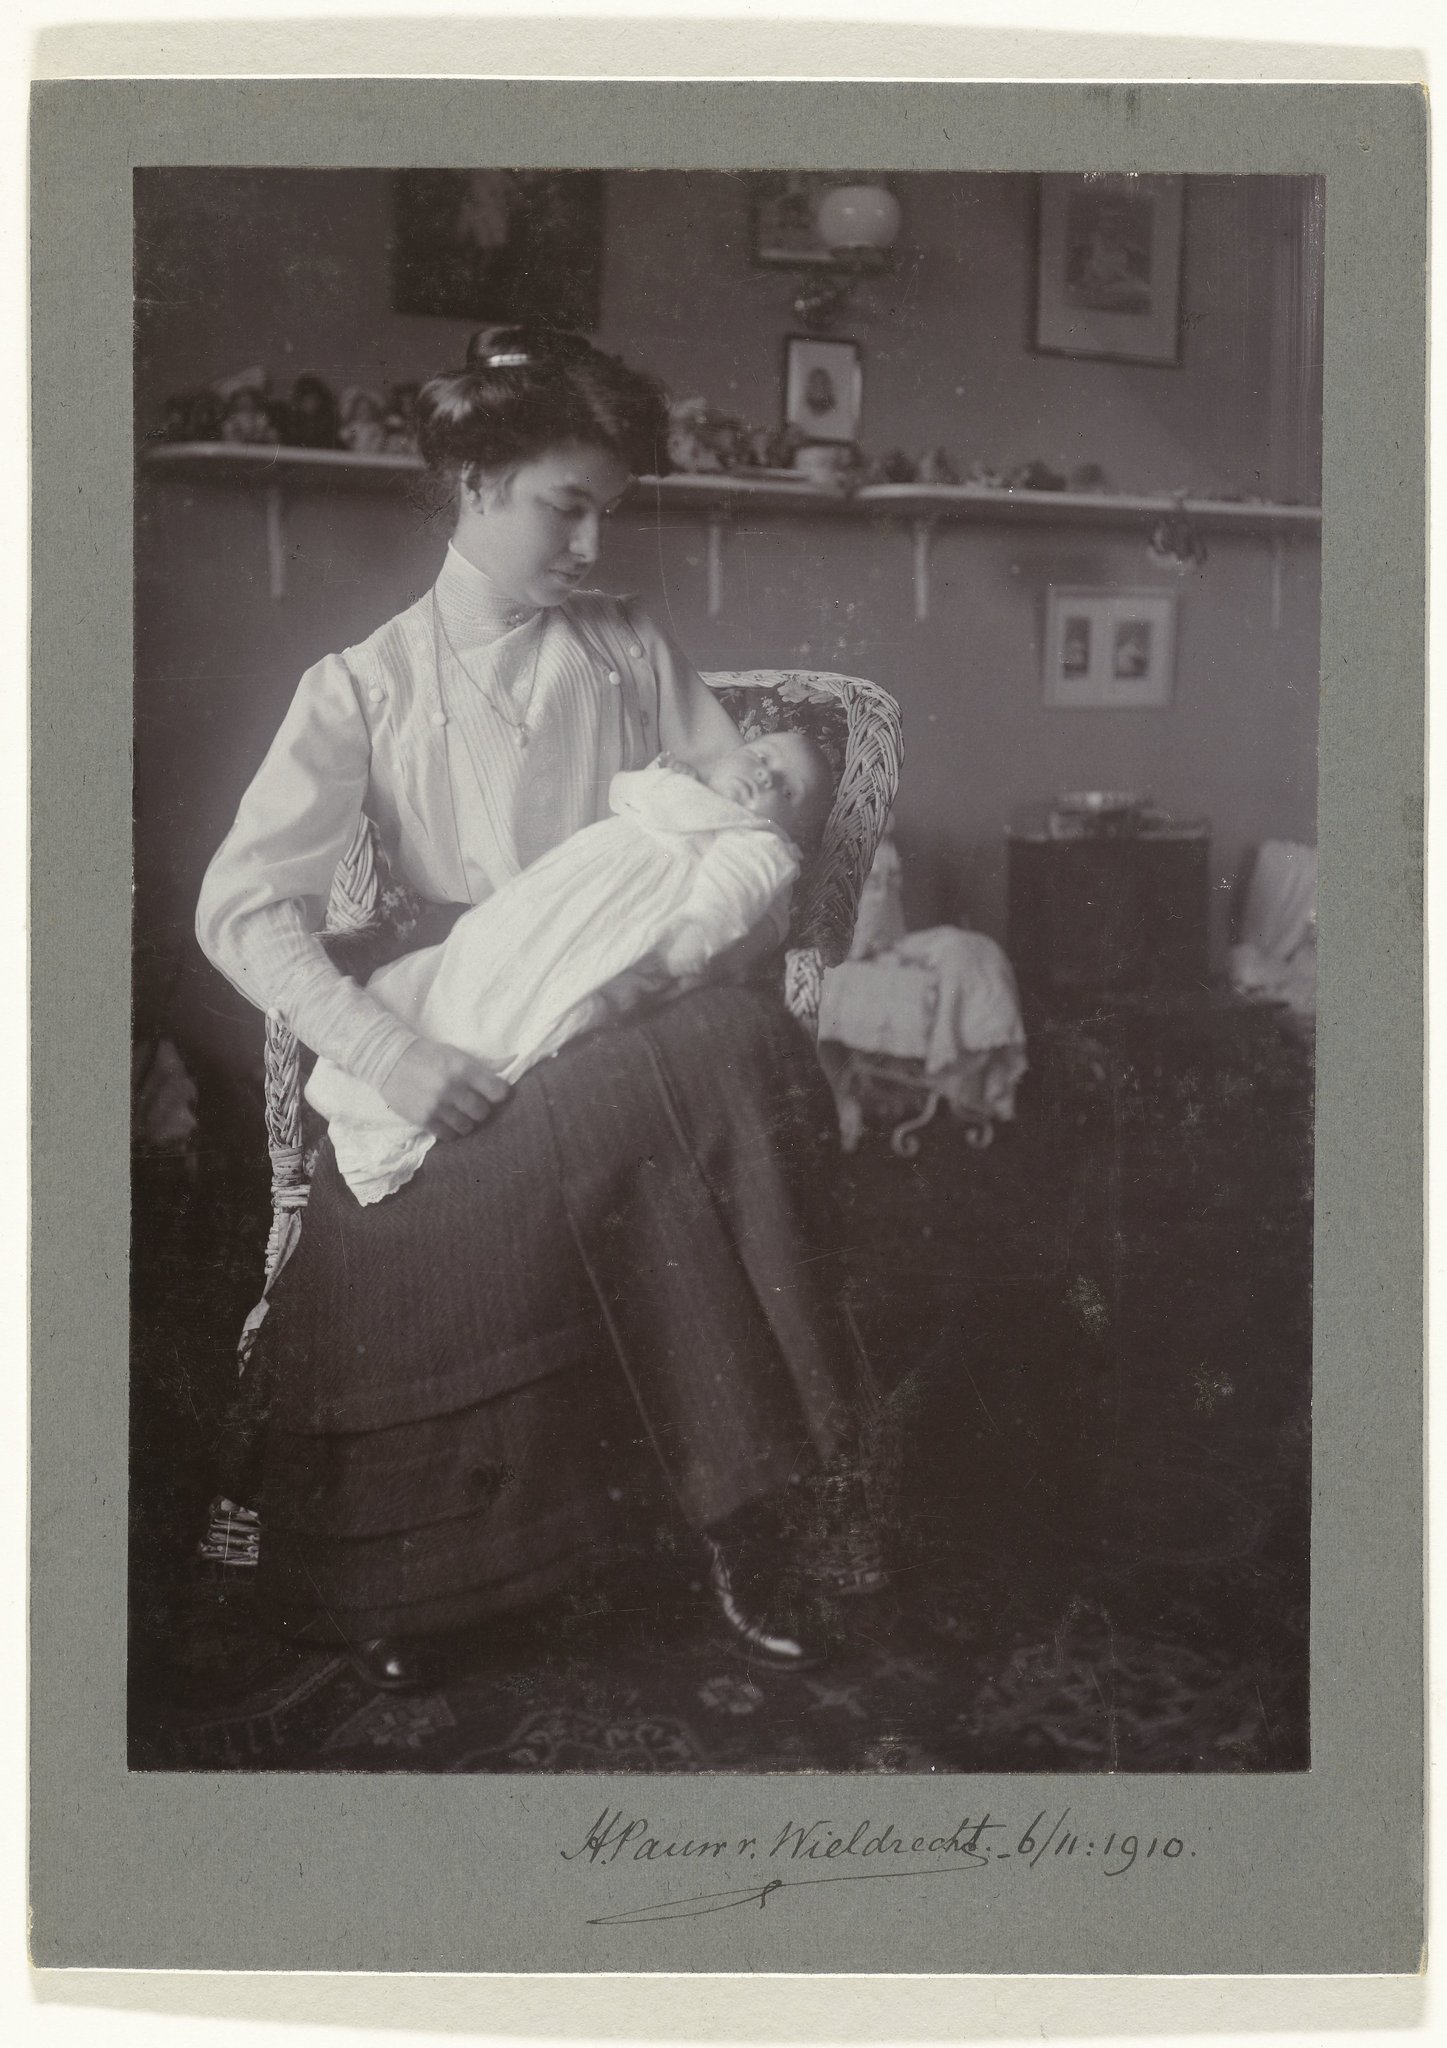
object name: photograph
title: 'Undernurse' Daisy met Dorothée, de jongste dochter van de fotograaf, op schoot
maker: henry pauw van wieldrecht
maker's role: fotograaf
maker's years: 1863-1912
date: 1910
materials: cardboard, photographic support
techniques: collodion silver print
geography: netherlands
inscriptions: annotation: ‘Daisy Undernurse / Baby’, annotation: ‘No 3815. / 1910.’, signature and date: ‘H. Pauw v. Wieldrecht. - 6/11:1910.’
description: Nanny Daisy met op schoot een baby, vermoedelijk Dorothea Anna Pauw van Wieldrecht.